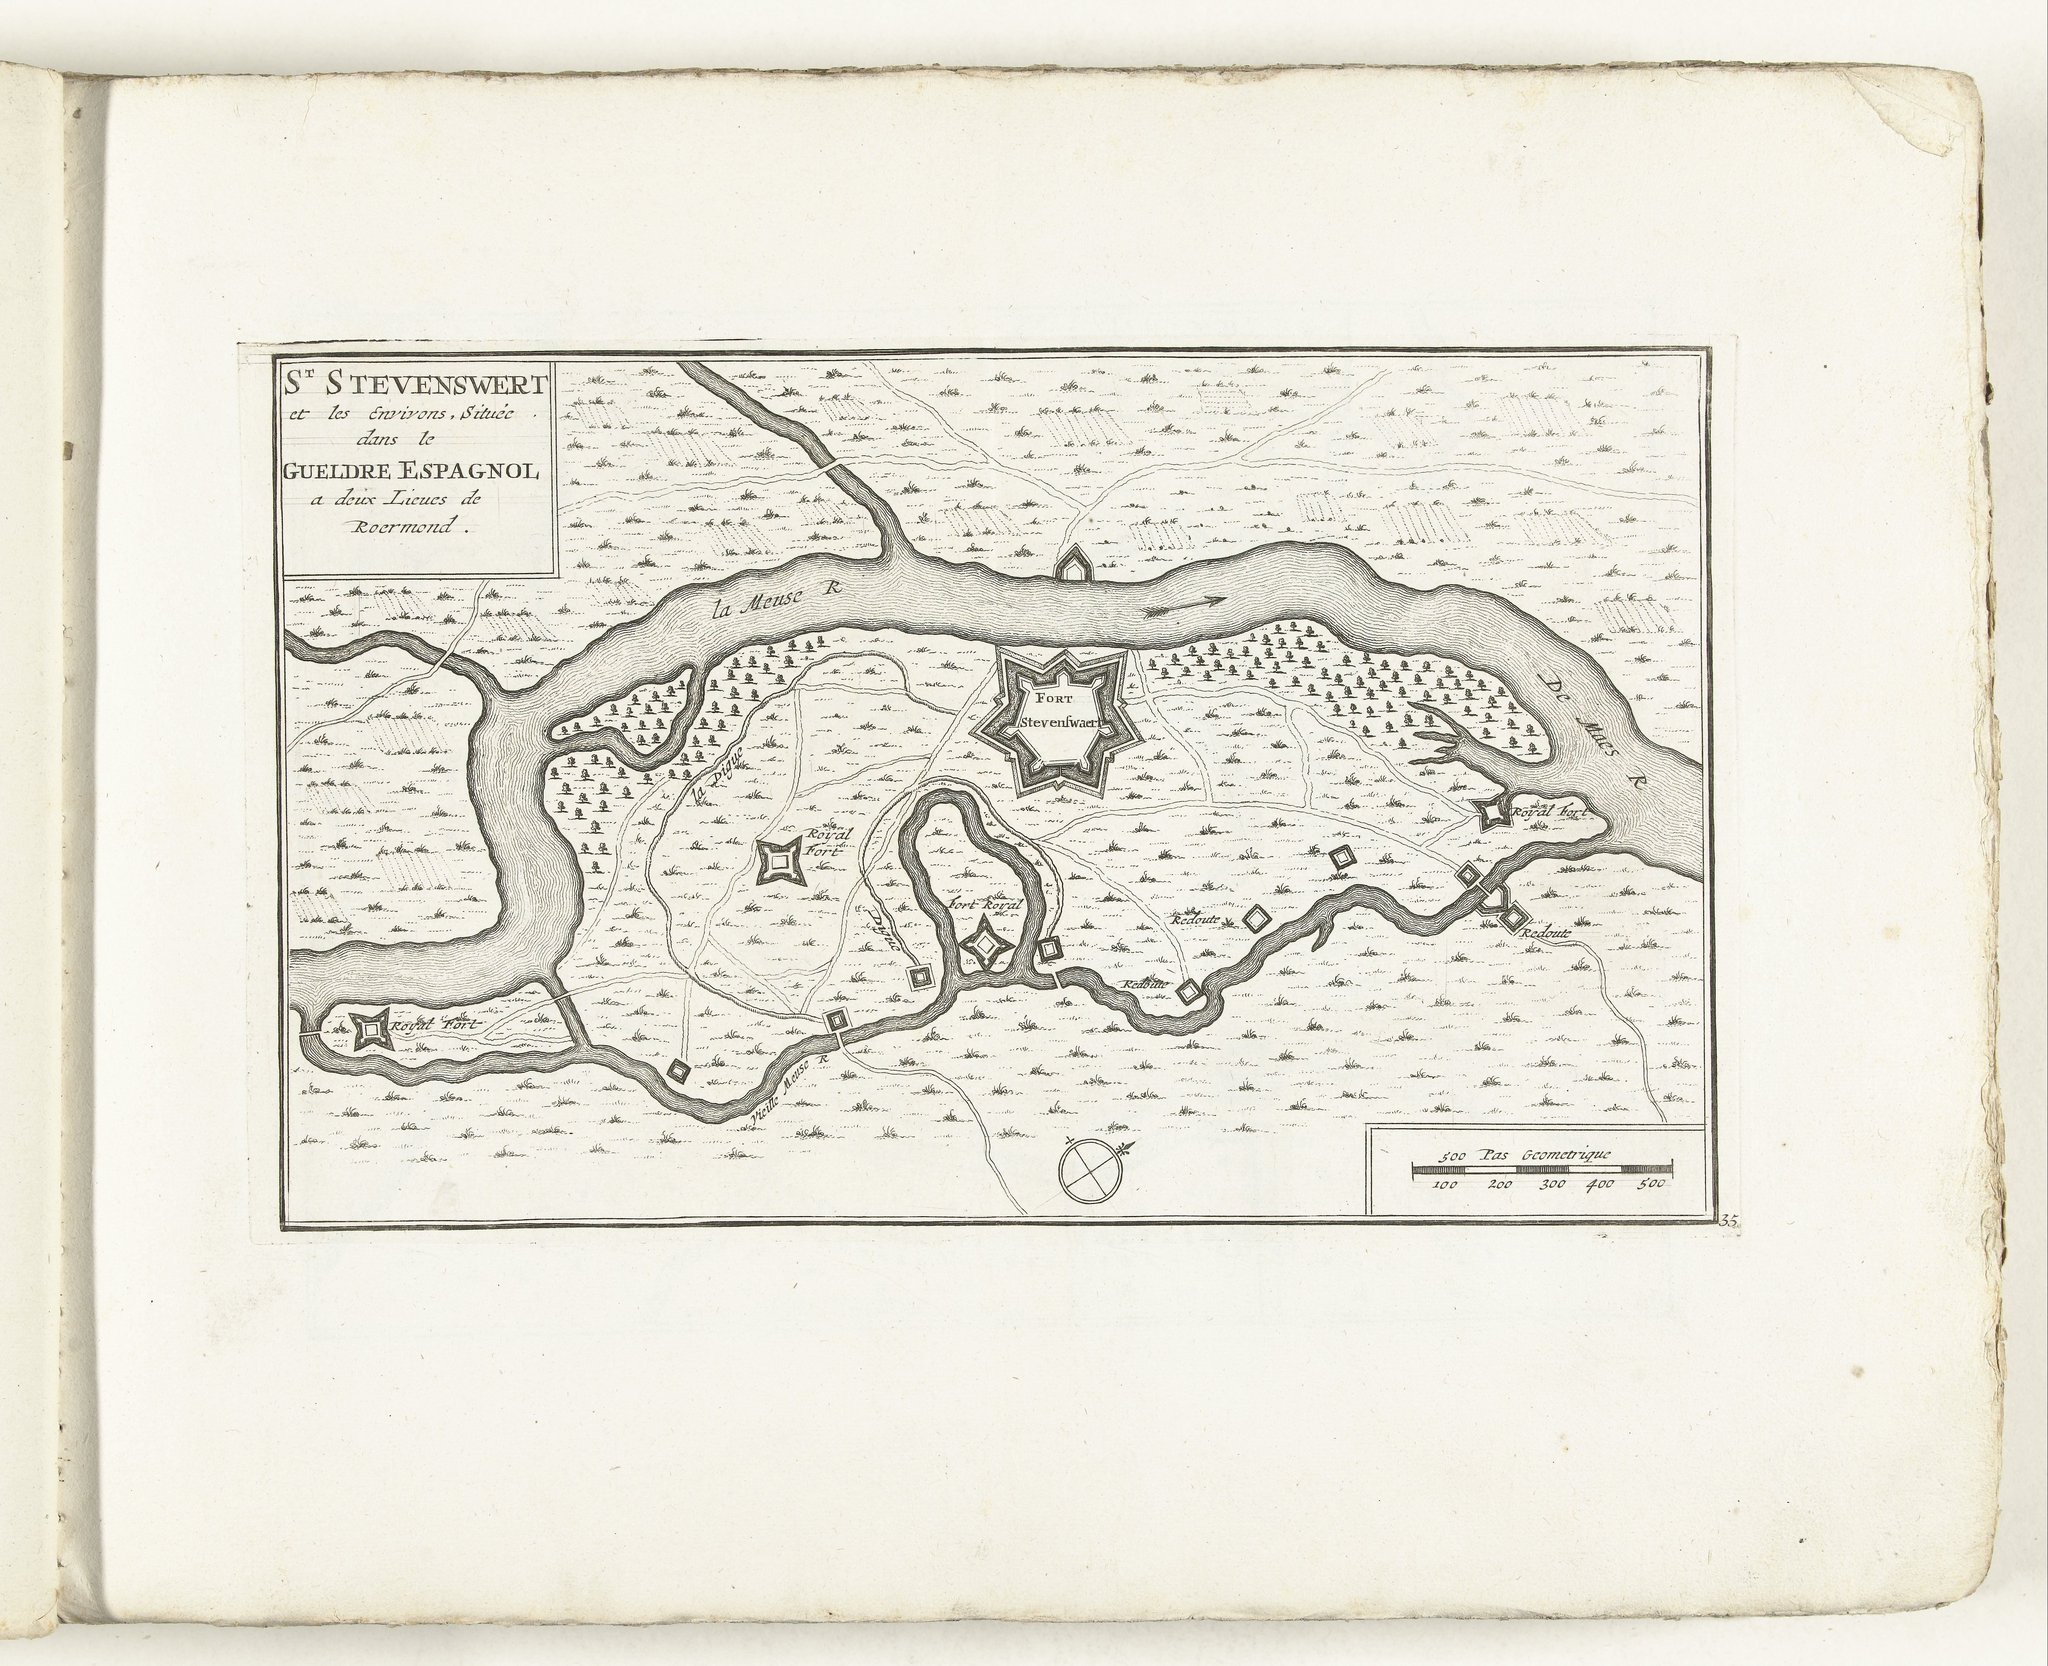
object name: print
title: St Stevenswert et les Environs, Située dans le Gueldre Espagnol (...)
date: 1702-1703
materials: paper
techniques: etching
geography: northern netherlands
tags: fortress, maps of cities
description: Plattegrond van de verdedigingswerken om de stad Stevensweert aan de Maas. Plaat nr. 35 in het prentwerk bestaande in totaal uit 276 genummerde platen van vermaarde sterke steden en vestingen in het kader van de Spaanse Successieoorlog. Voor het merendeel zijn deze platen gekopieerd naar de anonieme Franse platen: in Les forces de l'Europe en in: Le theatre de la guerre, dans les Pays-Bas, beide oorspronkelijk uitgegeven door Nicolas de Fer te Parijs (1693-1697) in het kader van de Negenjarige Oorlog. Titel en opschriften in de plaat in het Frans.